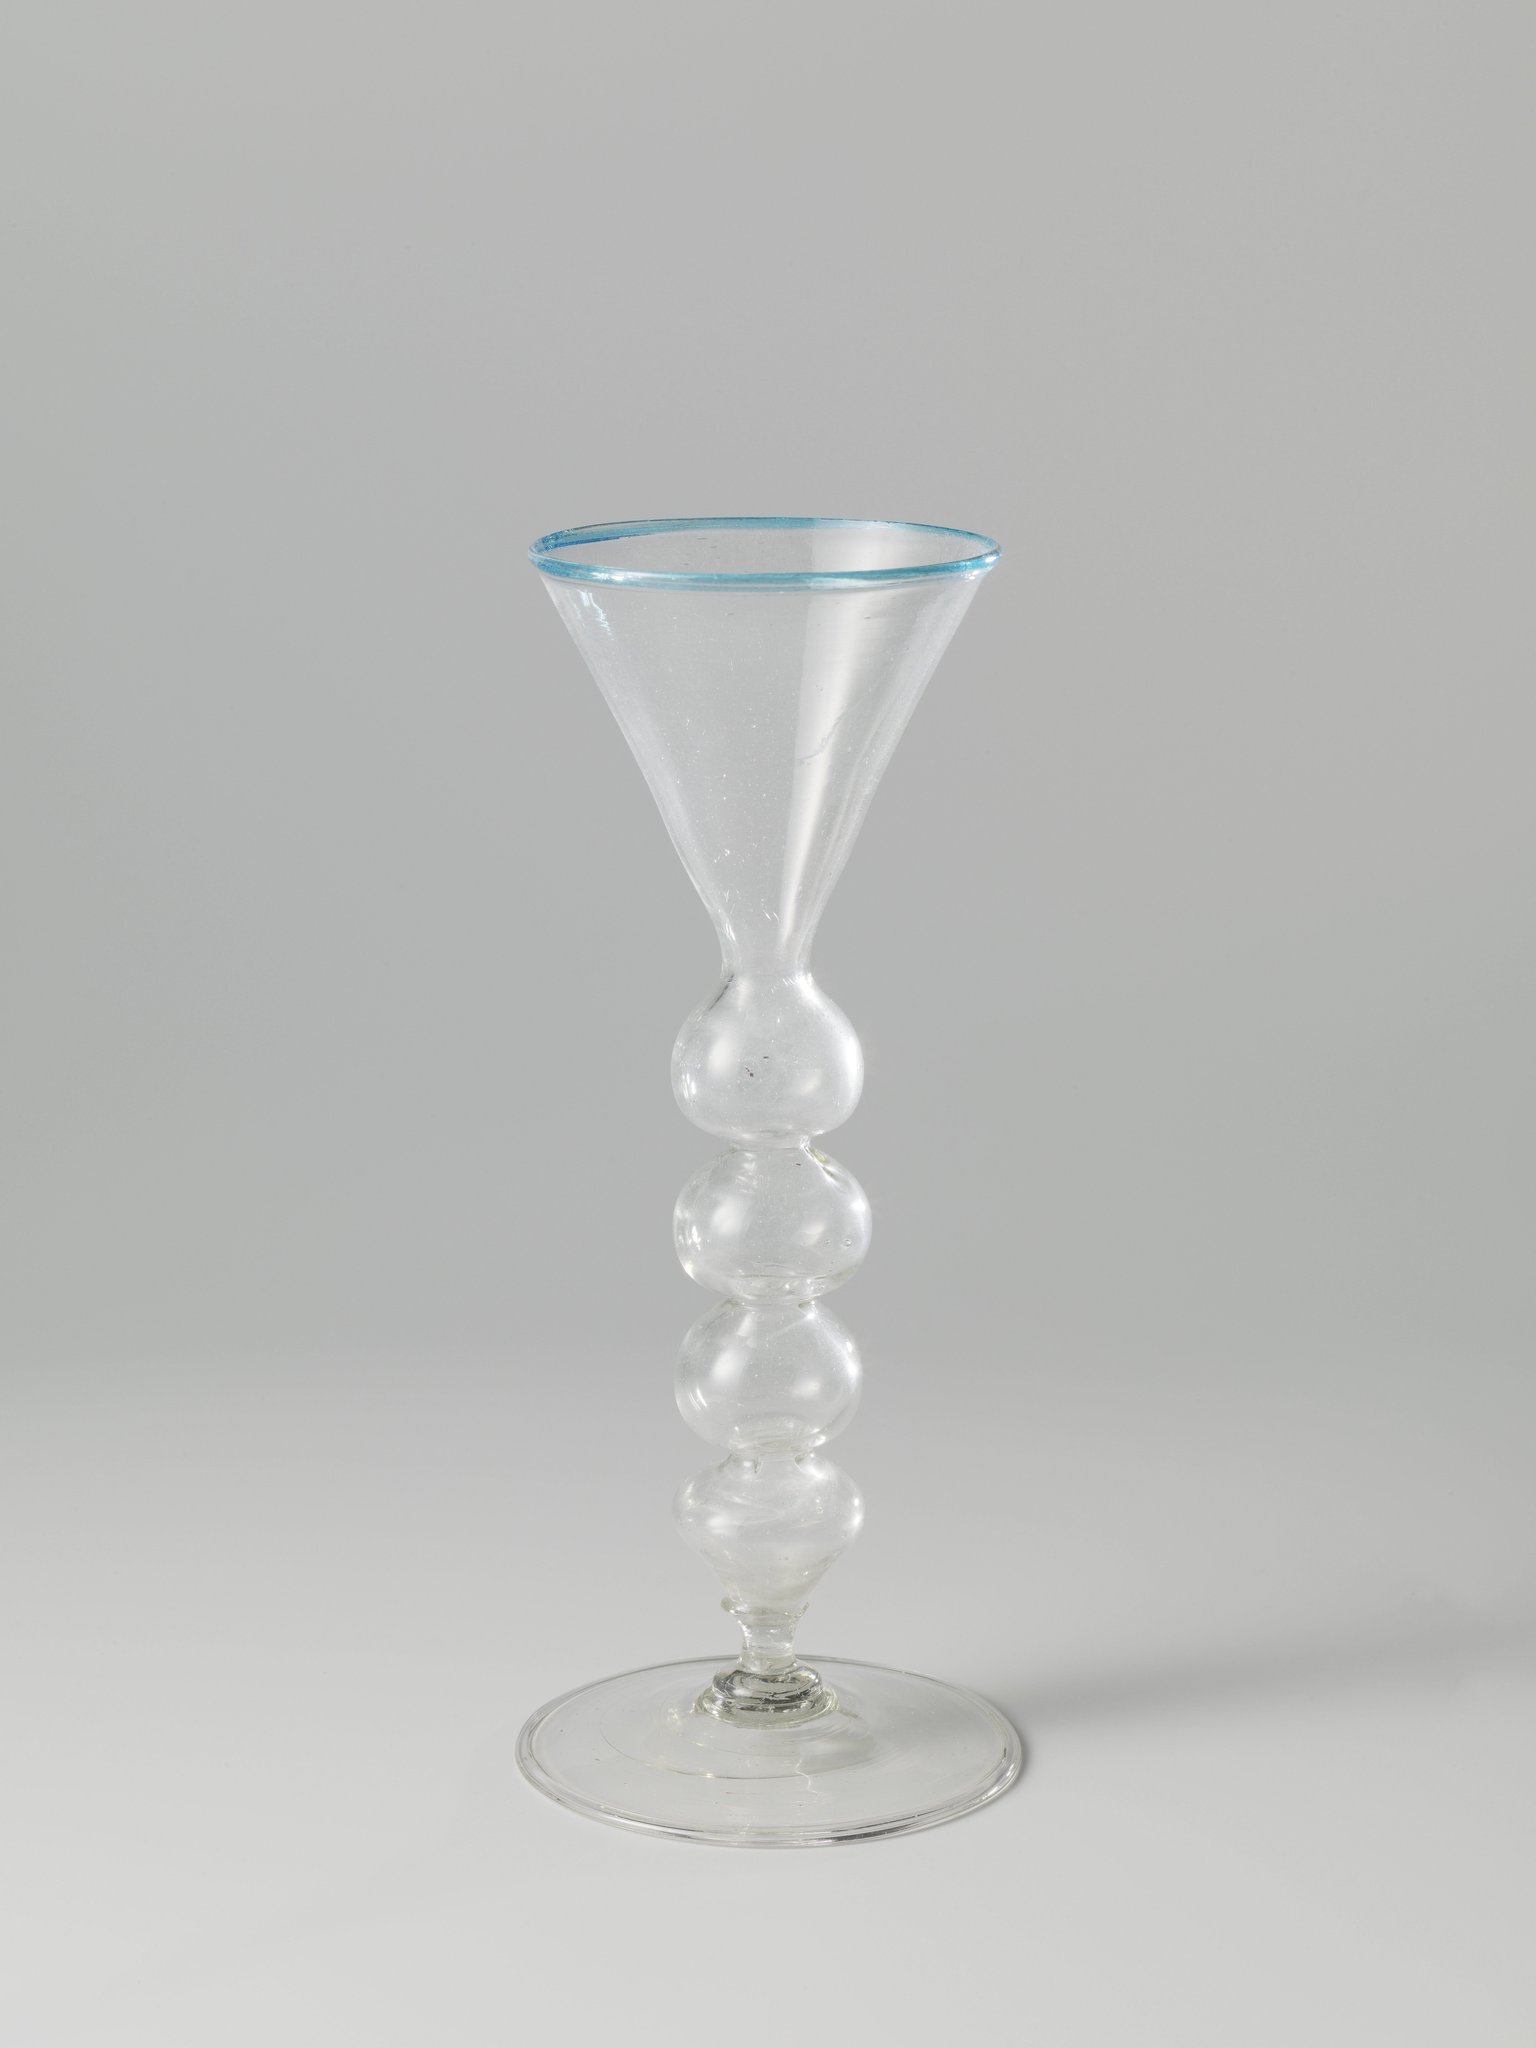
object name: goblet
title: Kelkglas met een holle stam met baluster en drie bollen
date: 1550-1650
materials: glass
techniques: façon de venise, glassblowing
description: Kelkglas met platte voet met omgeslagen rand. De stam, die is opgebouwd uit een holle baluster en drie bollen, staat in open verbinding met de trechtervormige kelk, die is afgezet met een blauwe draad.